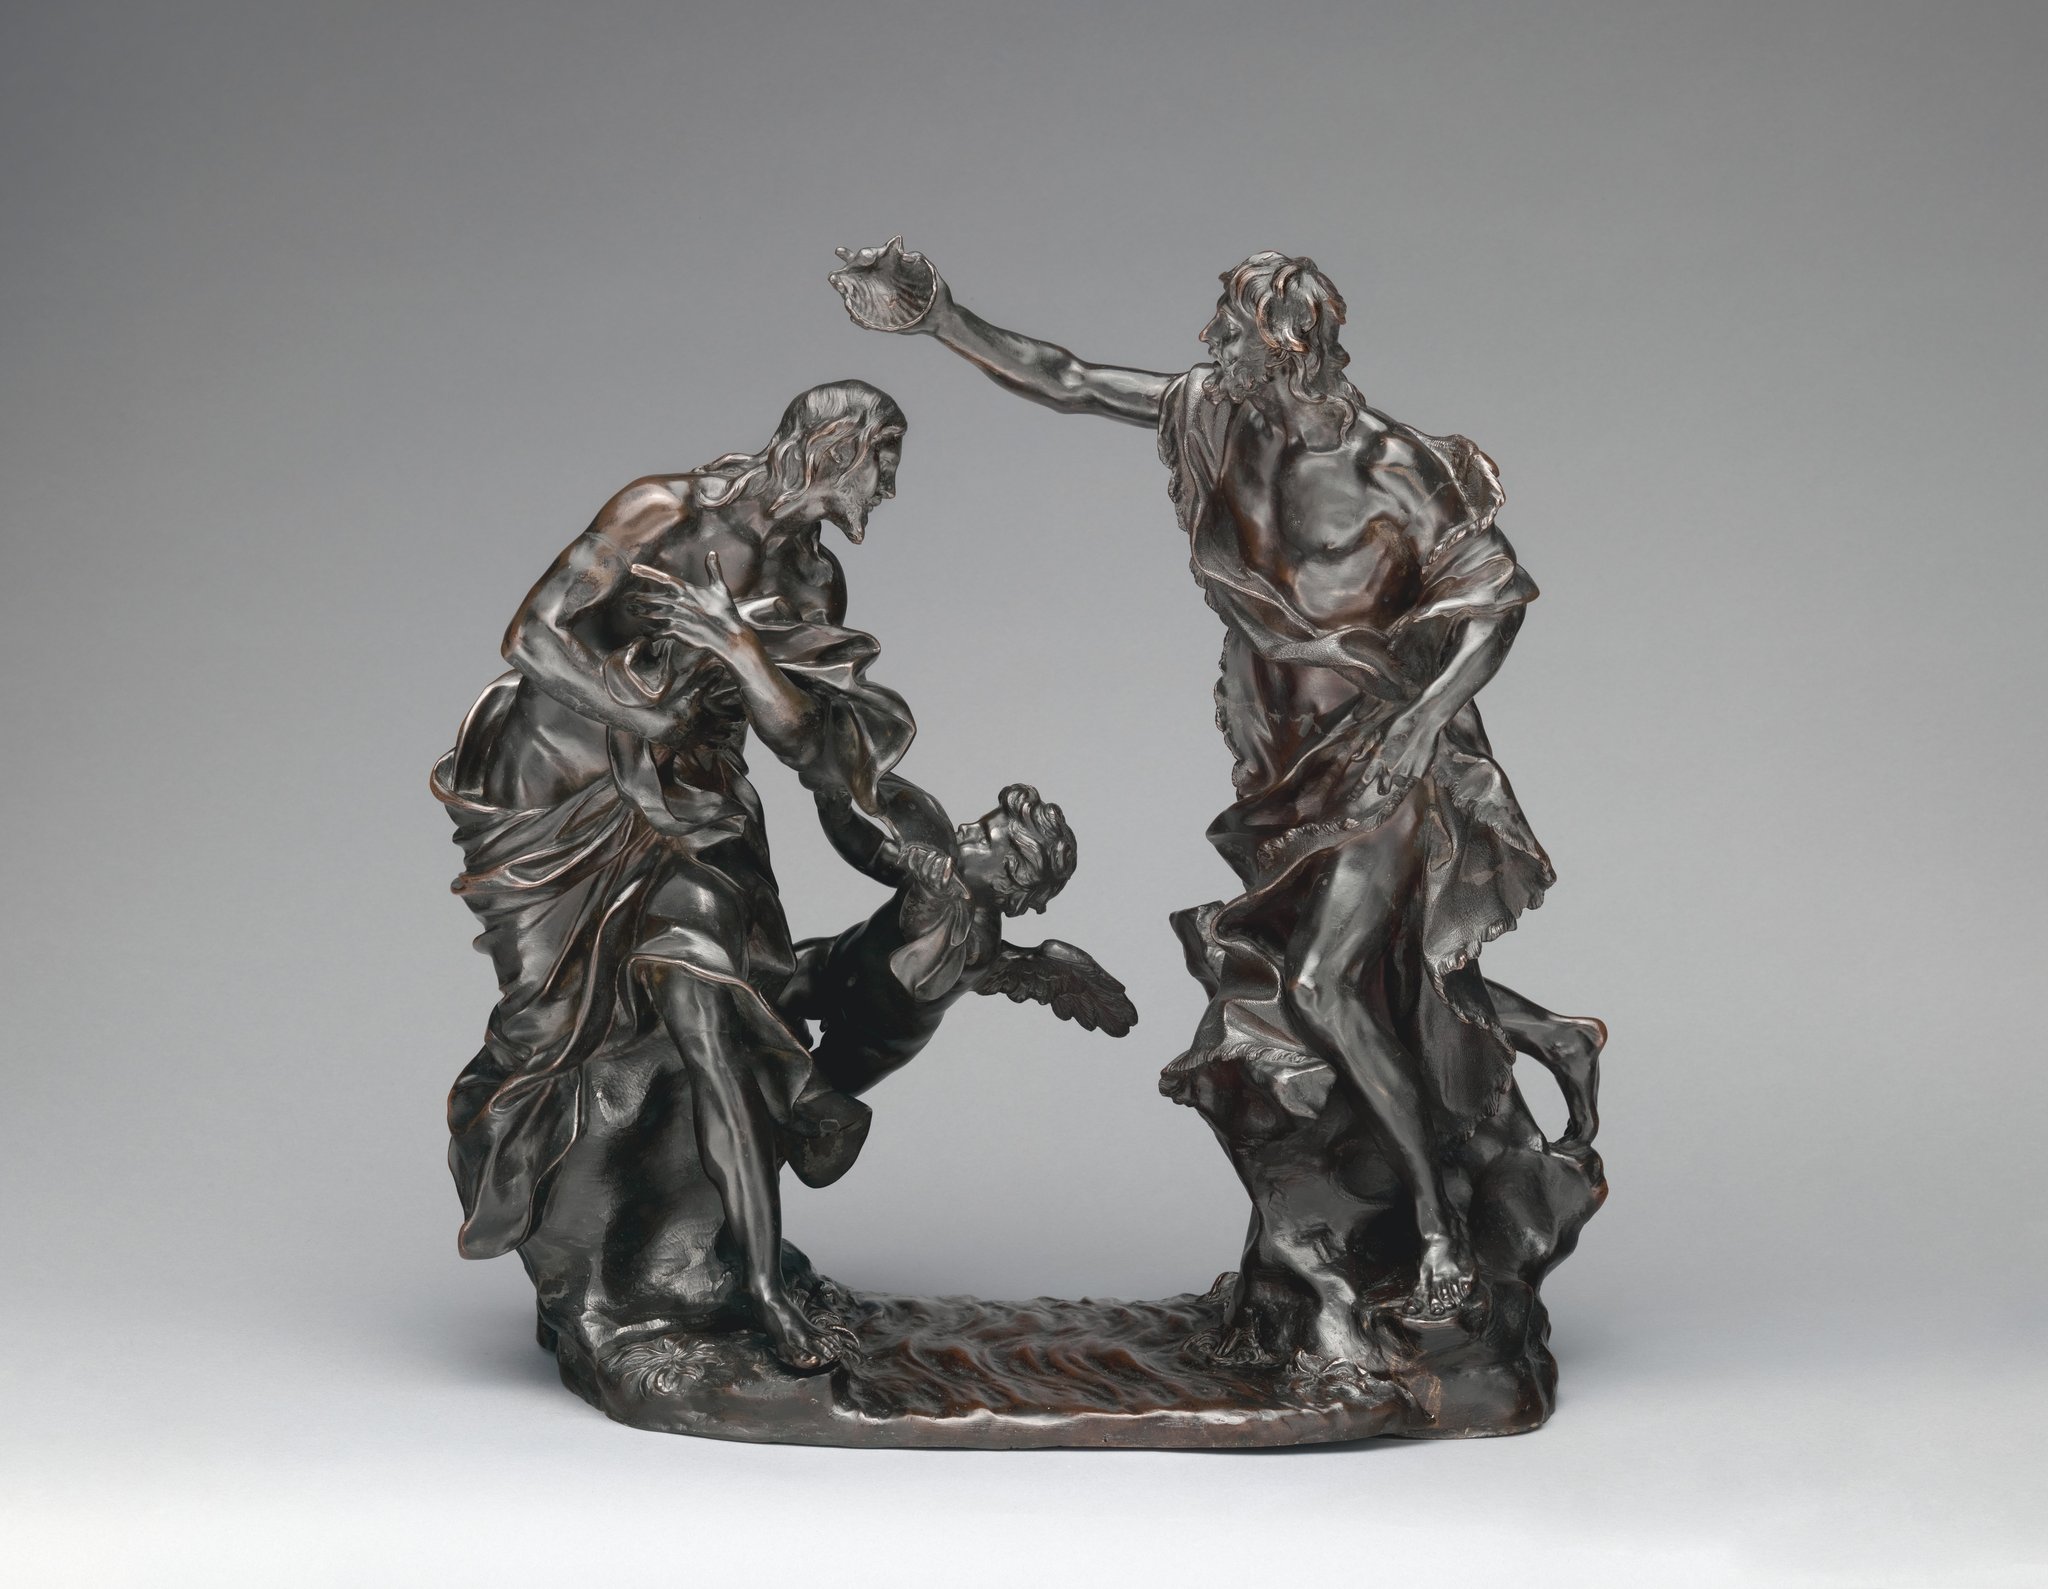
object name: statuette group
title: Baptism of Christ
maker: alessandro algardi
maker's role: artist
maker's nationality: italian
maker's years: 1598-1654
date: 1651-1700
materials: bronze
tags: angels,christ,baptism of christ,saints